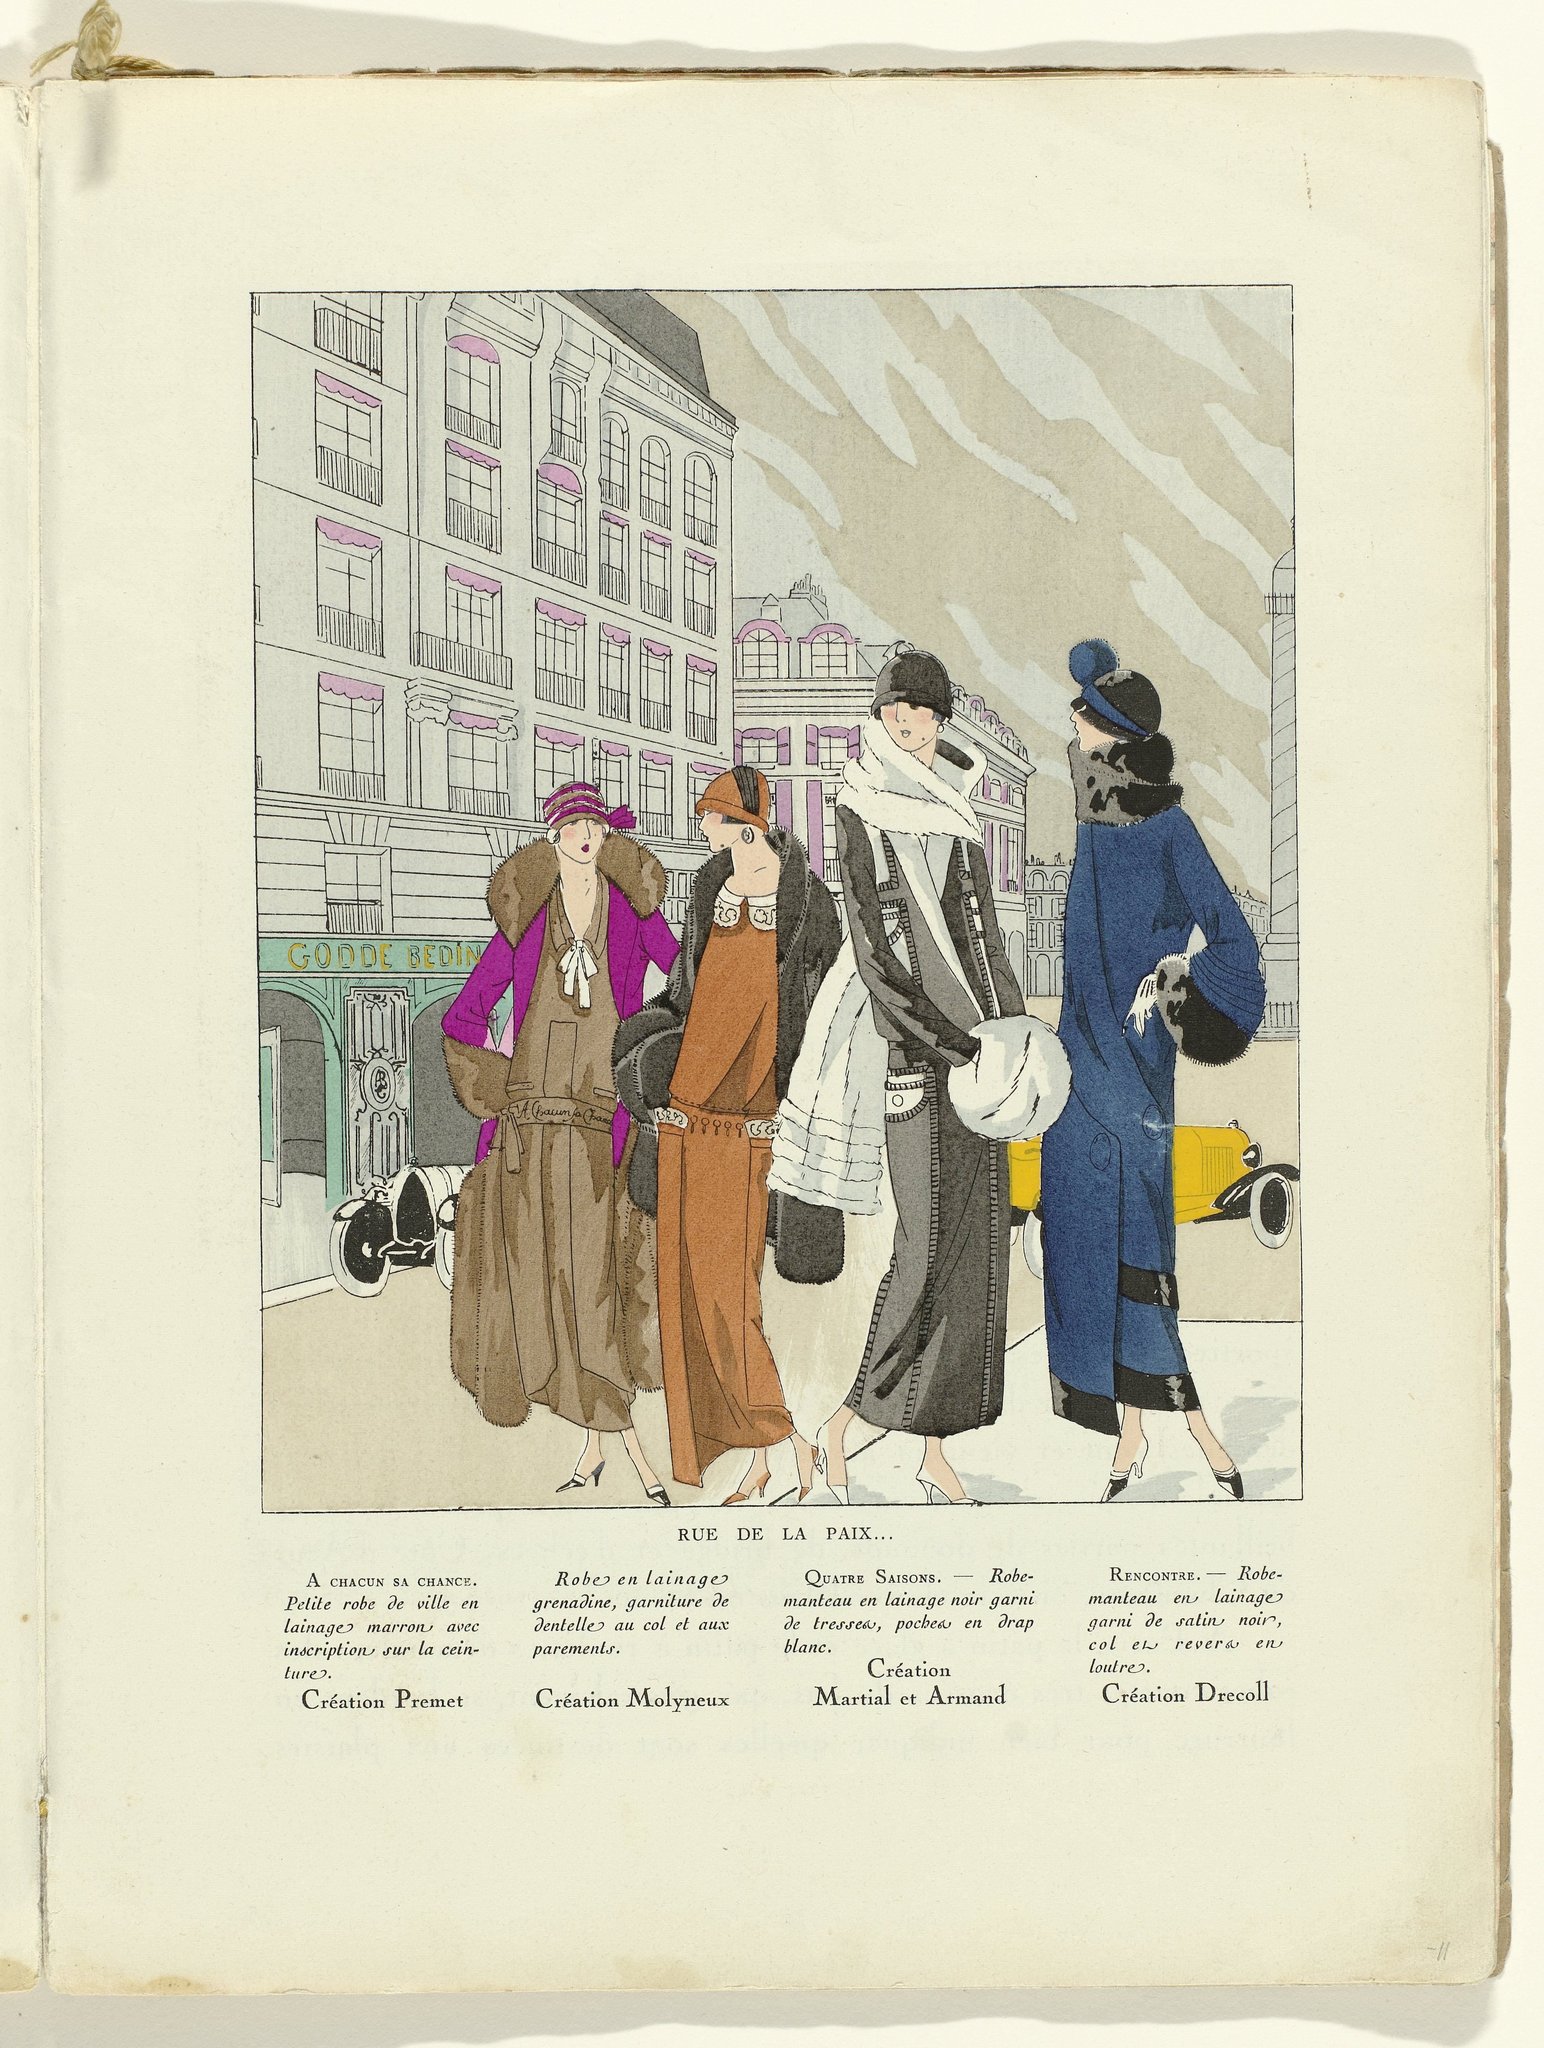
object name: magazine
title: Art - Goût - Beauté, Feuillets de l' élégance féminine, Janvier 1924, No. 41, 4e Année, p. 11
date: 1924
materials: paper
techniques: hand coloring, lithograph, pochoir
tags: dress, gown (robe manteau) (+ women's clothes), coat (+ women's clothes), fashion plates, head-gear: hat (+ women's clothes), street, belt, girdle, waistband (+ women's clothes)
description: De Rue de la Paix in Parijs, met vier dames in creaties van Premet, Molyneux, Martial et Armand en Drecoll. Pagina uit het modetijdschrift Art-Goût-Beauté (1920-1933).